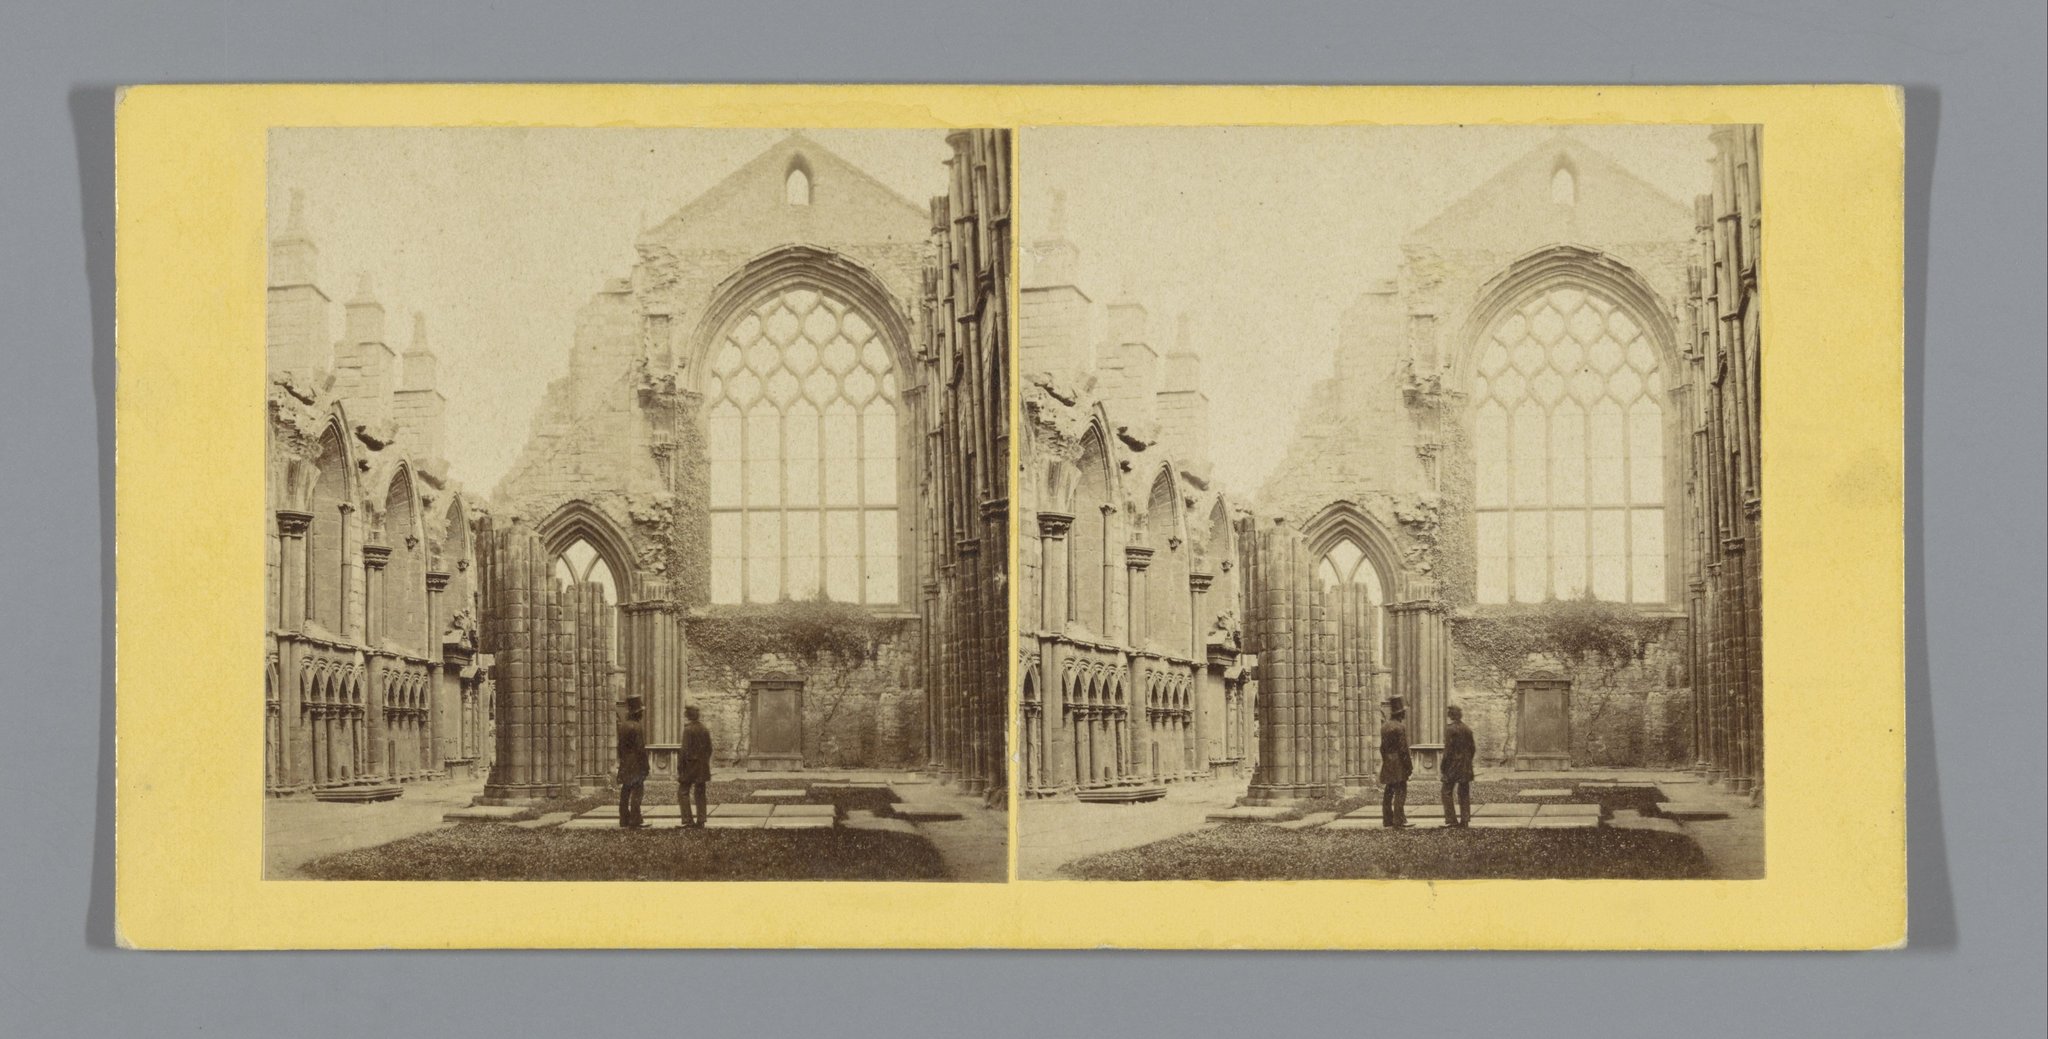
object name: stereograph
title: Interieur van een kapel van de ruïne van de Holyrood Abbey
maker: Anonymous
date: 1850-1880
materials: cardboard, photographic support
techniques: albumen print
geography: holyrood abbey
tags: parts of church interior: chapel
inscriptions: number: ‘No. 87.’, inscription: ‘Interior of Holyrood Chapel’